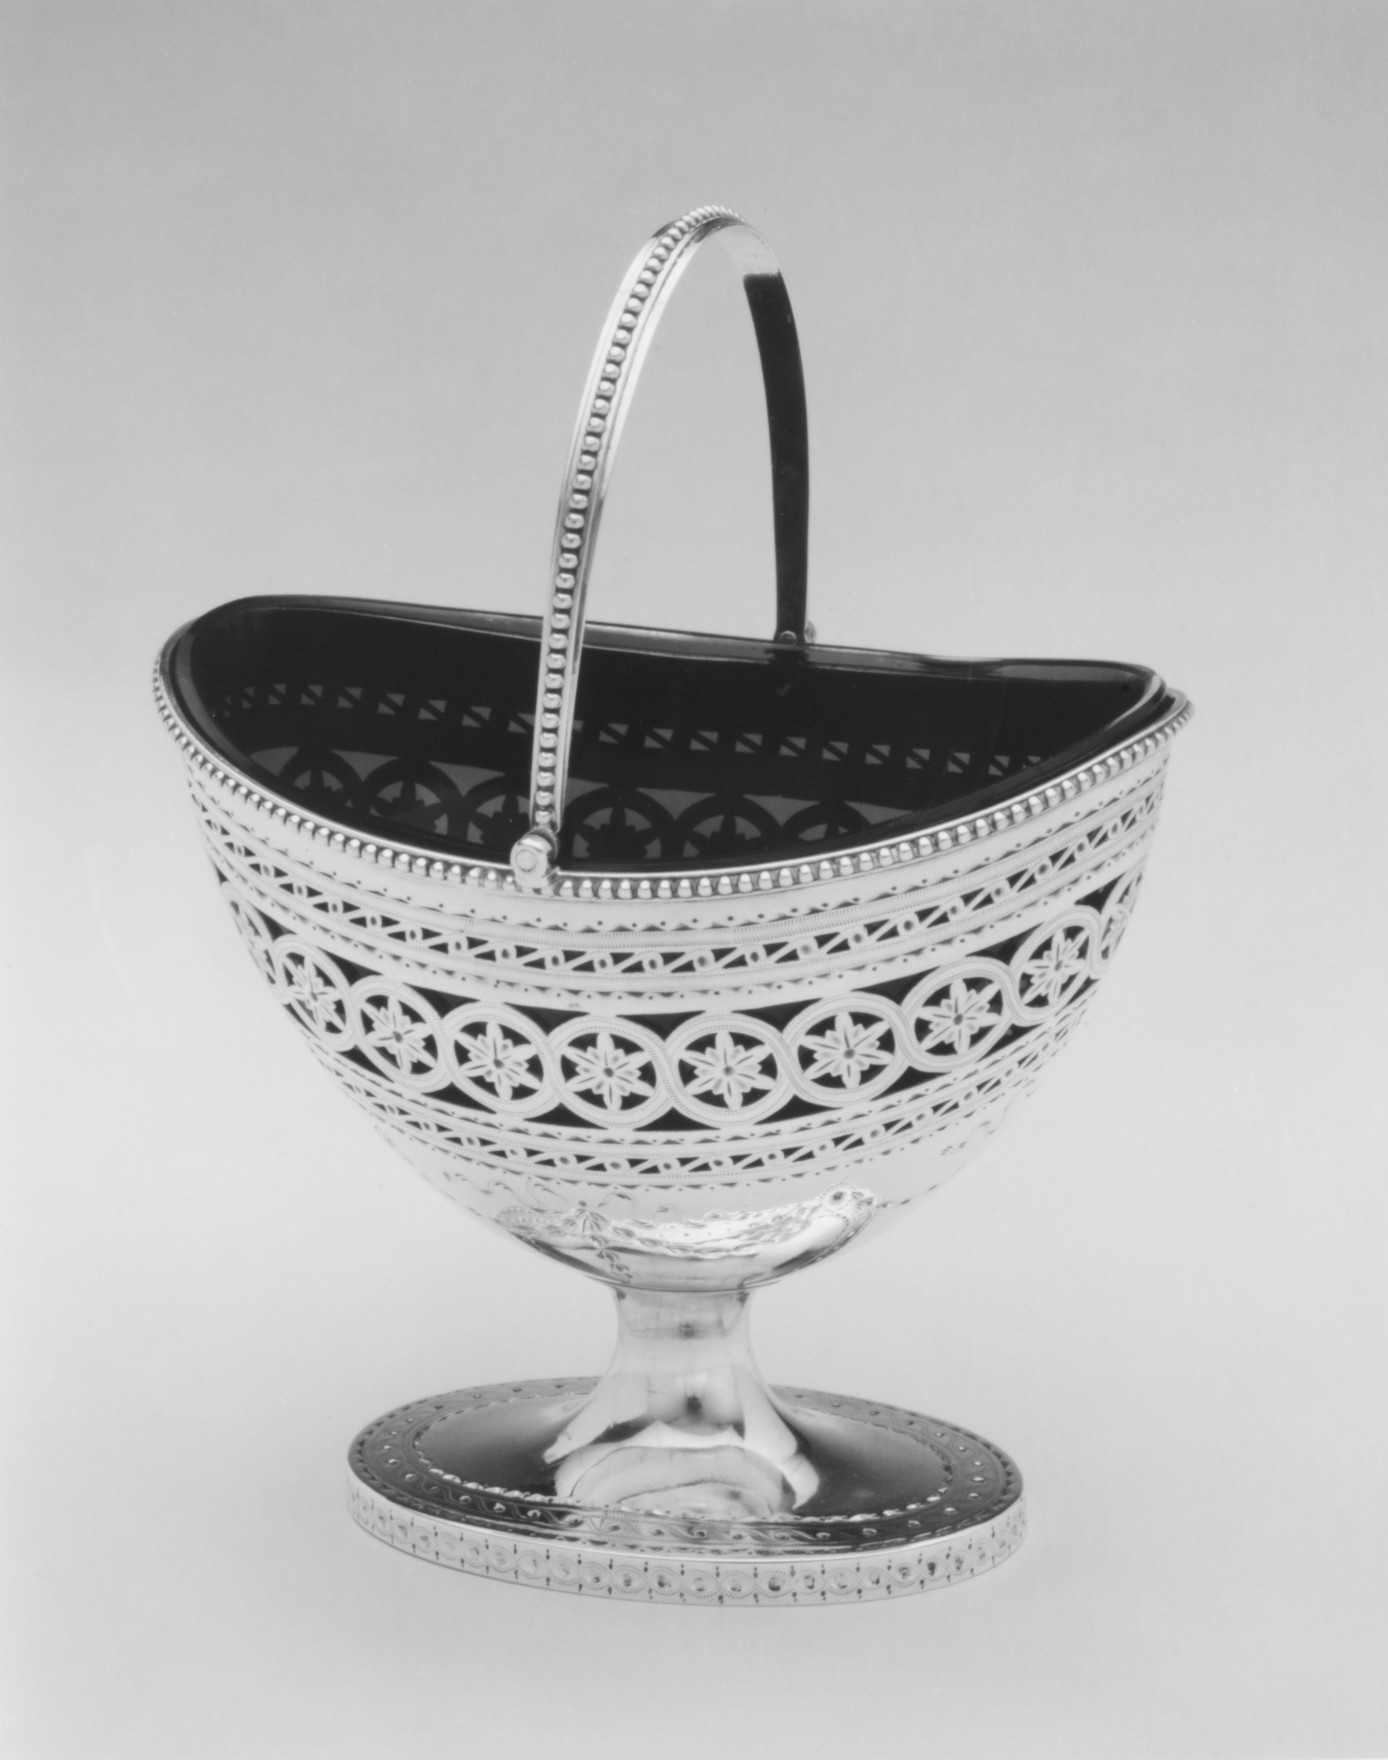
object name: basket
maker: robert hennell i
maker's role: maker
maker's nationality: british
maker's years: 1741-1811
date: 1783-1784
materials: glass, silver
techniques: lining